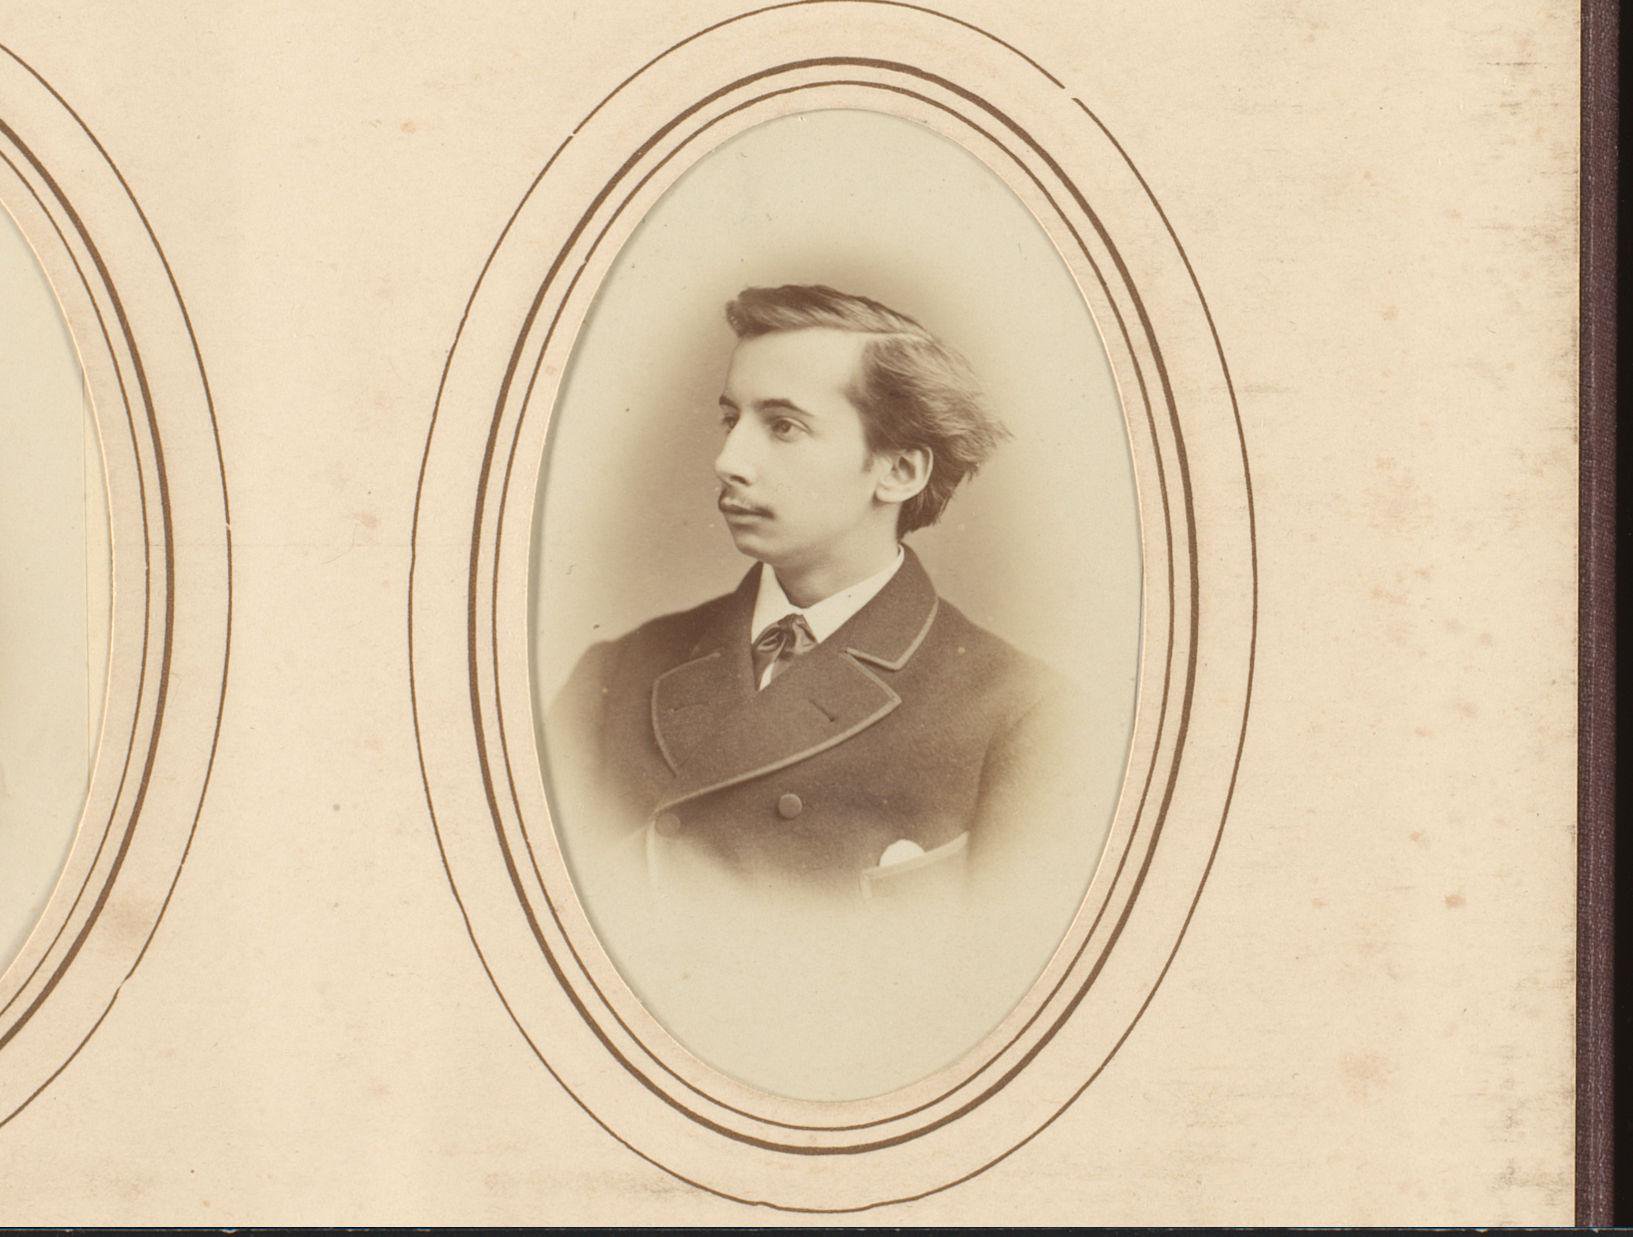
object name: photograph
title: Portret van een man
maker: albert greiner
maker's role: fotograaf, fotostudio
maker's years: 1833-1890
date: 1860-1885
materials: cardboard, photographic support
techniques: albumen print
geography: amsterdam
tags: adult man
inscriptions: inscription: ‘AG/ A. Greiner/ Photograf/ Nieuwendijk, L. 87/ Amsterdam’, inscription: ‘A. Greiner, Phot. / Amsterdam.’